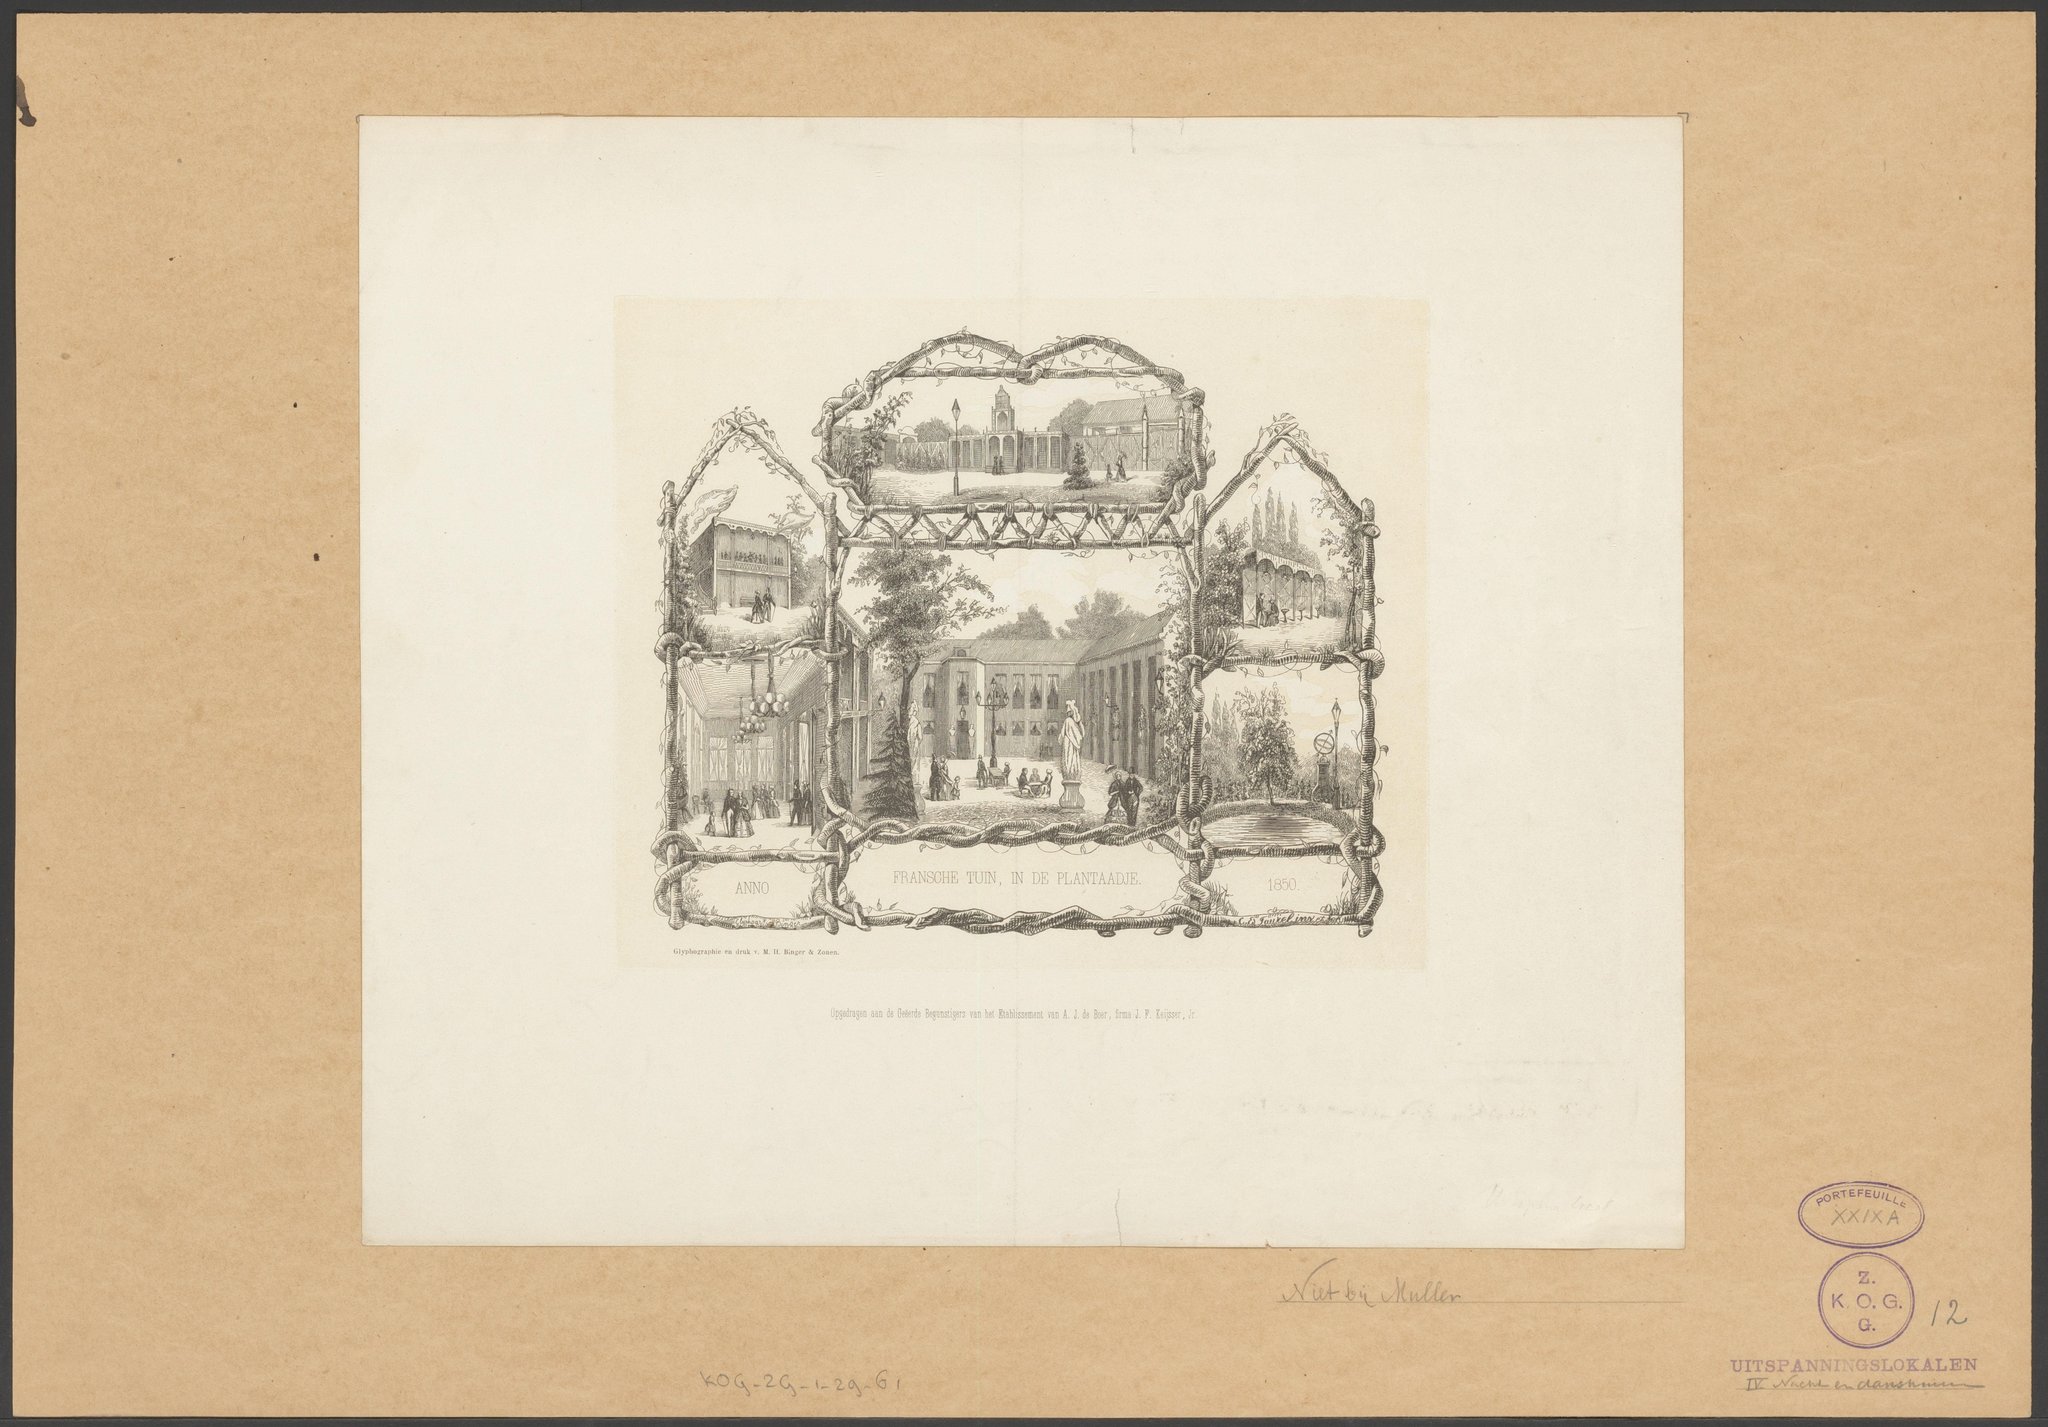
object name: print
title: Fransche tuin, in de plantaadje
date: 1850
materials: paper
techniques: gypsography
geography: amsterdam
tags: french or architectonic garden; formal garden, tea garden, garden restaurant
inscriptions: stamp, stamp, collector's mark: Lugt 1641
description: Onderwerpsrubrieken binnen de Atlas Zeden en Gewoonten: Zeden en gewoonten in engeren zin, Volksleven, Uitspanningslokalen, Nacht- en danshuizen, De Fransche tuin.